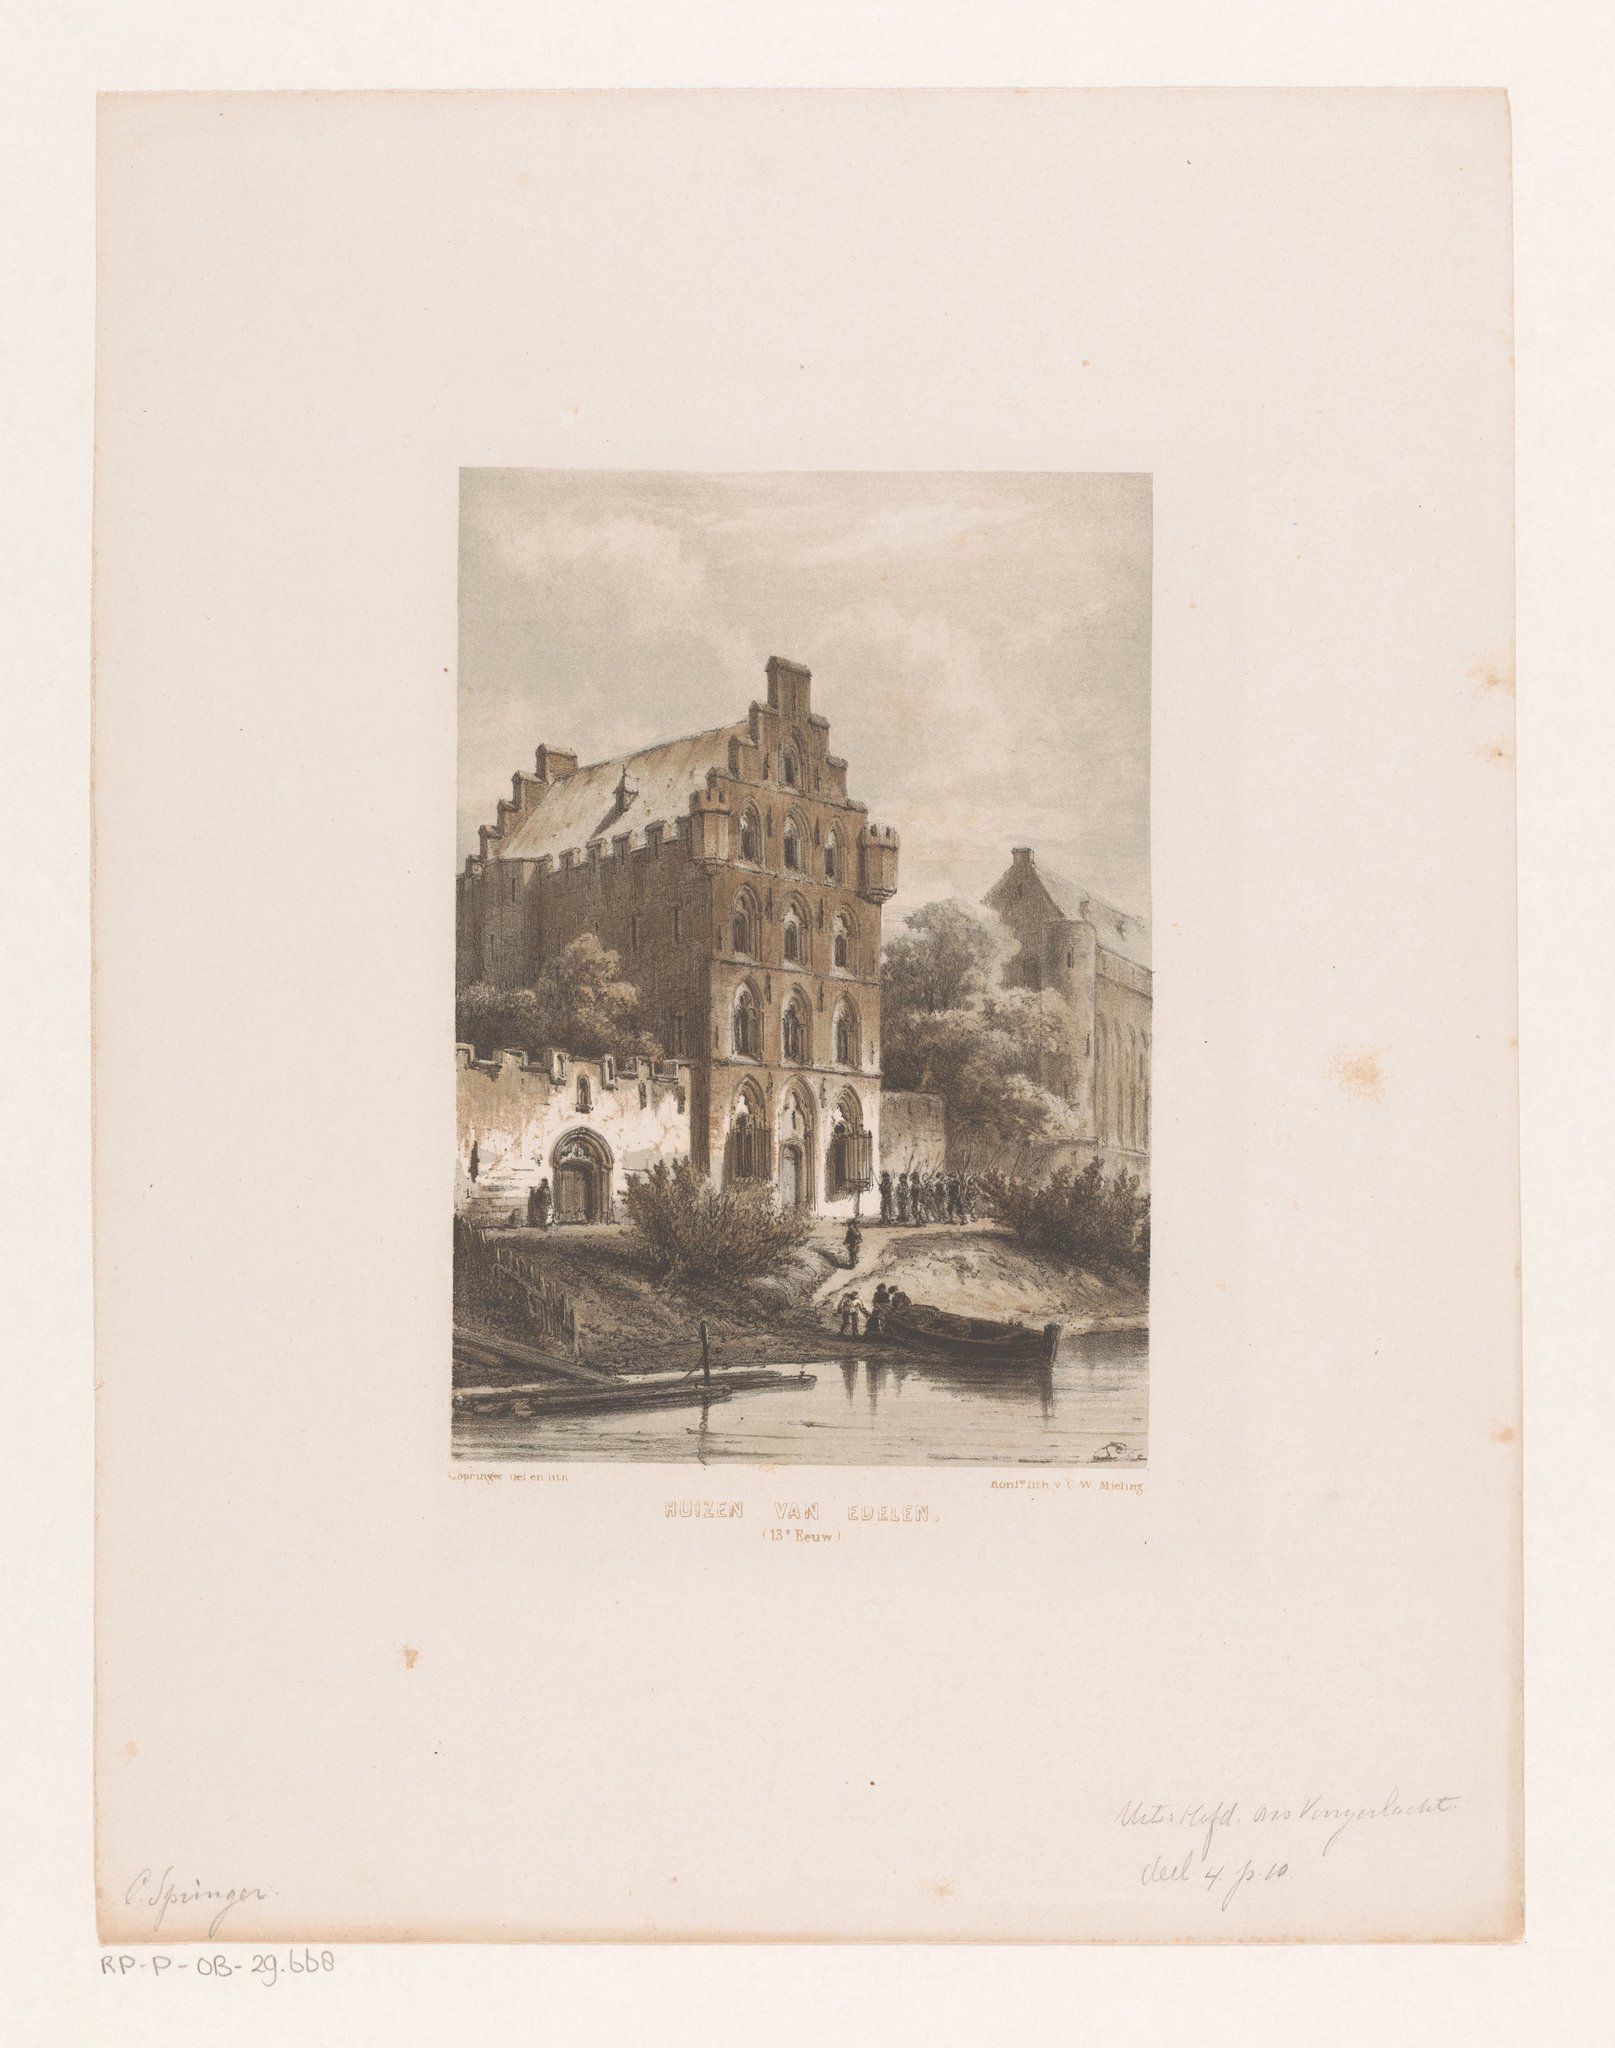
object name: print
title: Huizen van edelen (13e Eeuw)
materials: paper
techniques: tone lithography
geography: the hague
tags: landscapes with waters, waterscapes, seascapes (in the temperate zone), housing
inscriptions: collector's mark: Lugt 2228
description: Een boot legt aan op een oever. Daarachter loopt een groep soldaten voorbij huizen.